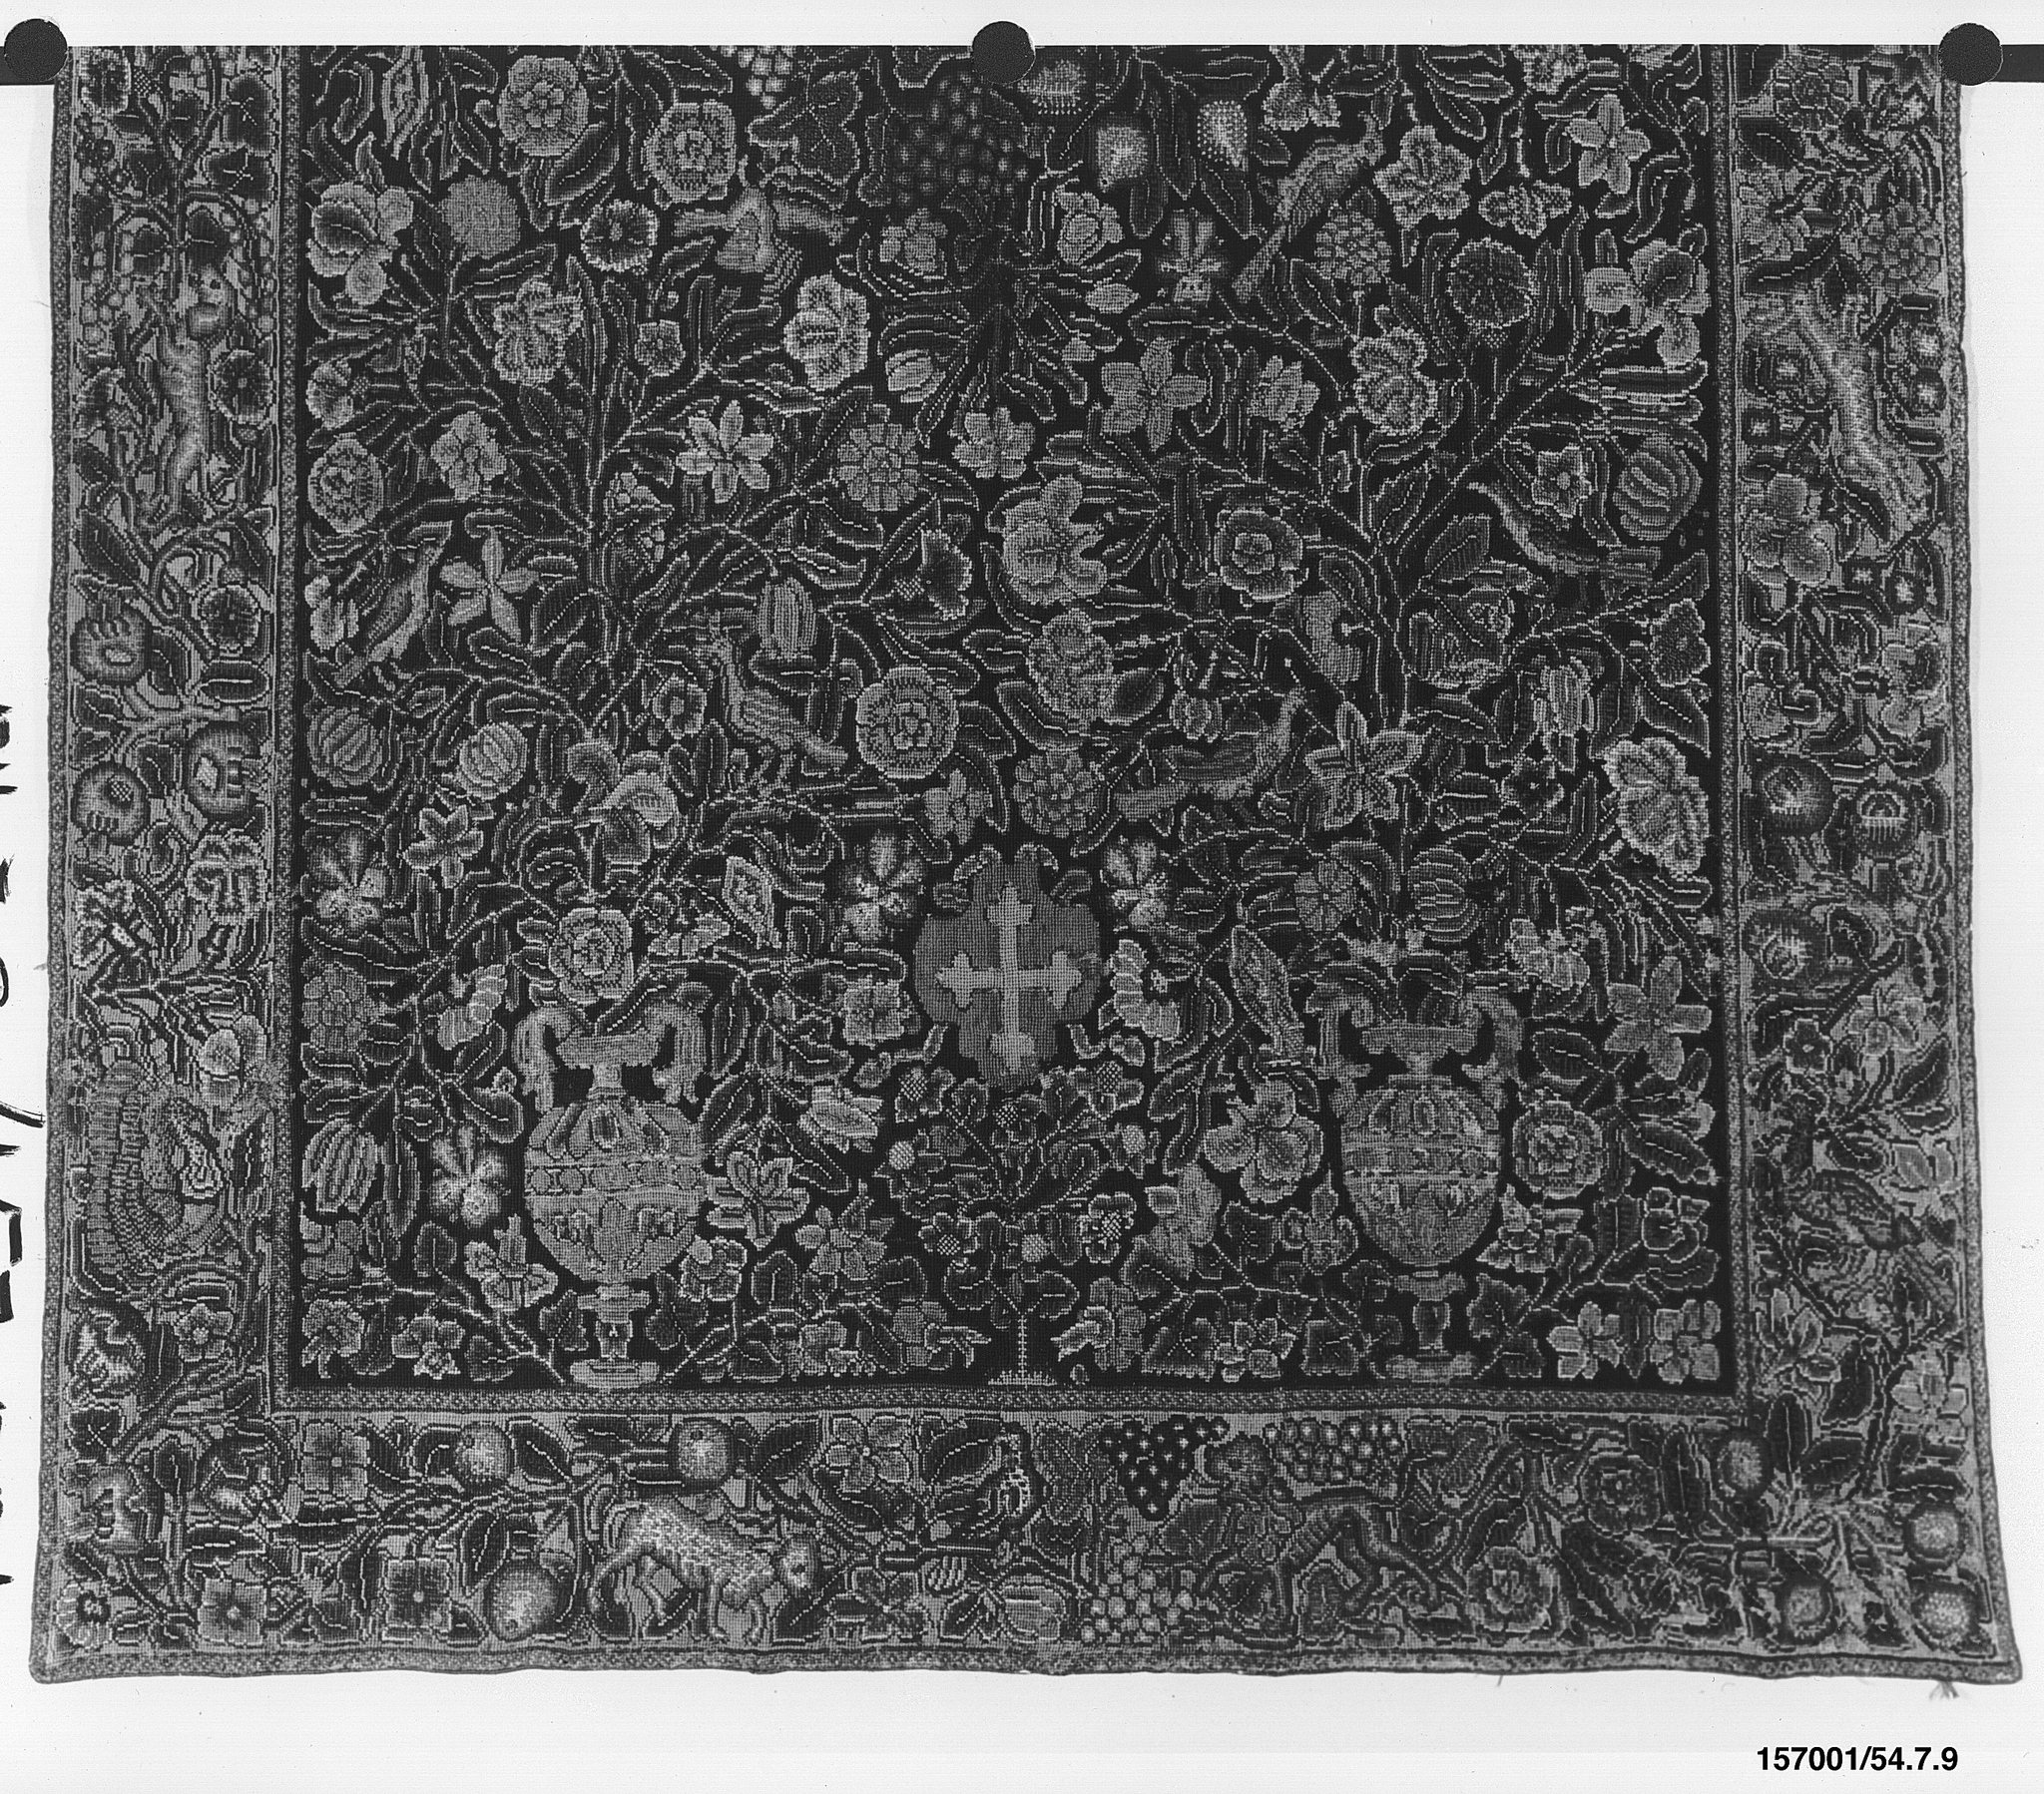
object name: table cover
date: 1601-1633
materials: canvas, silk, wool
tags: birds,flowers,cross